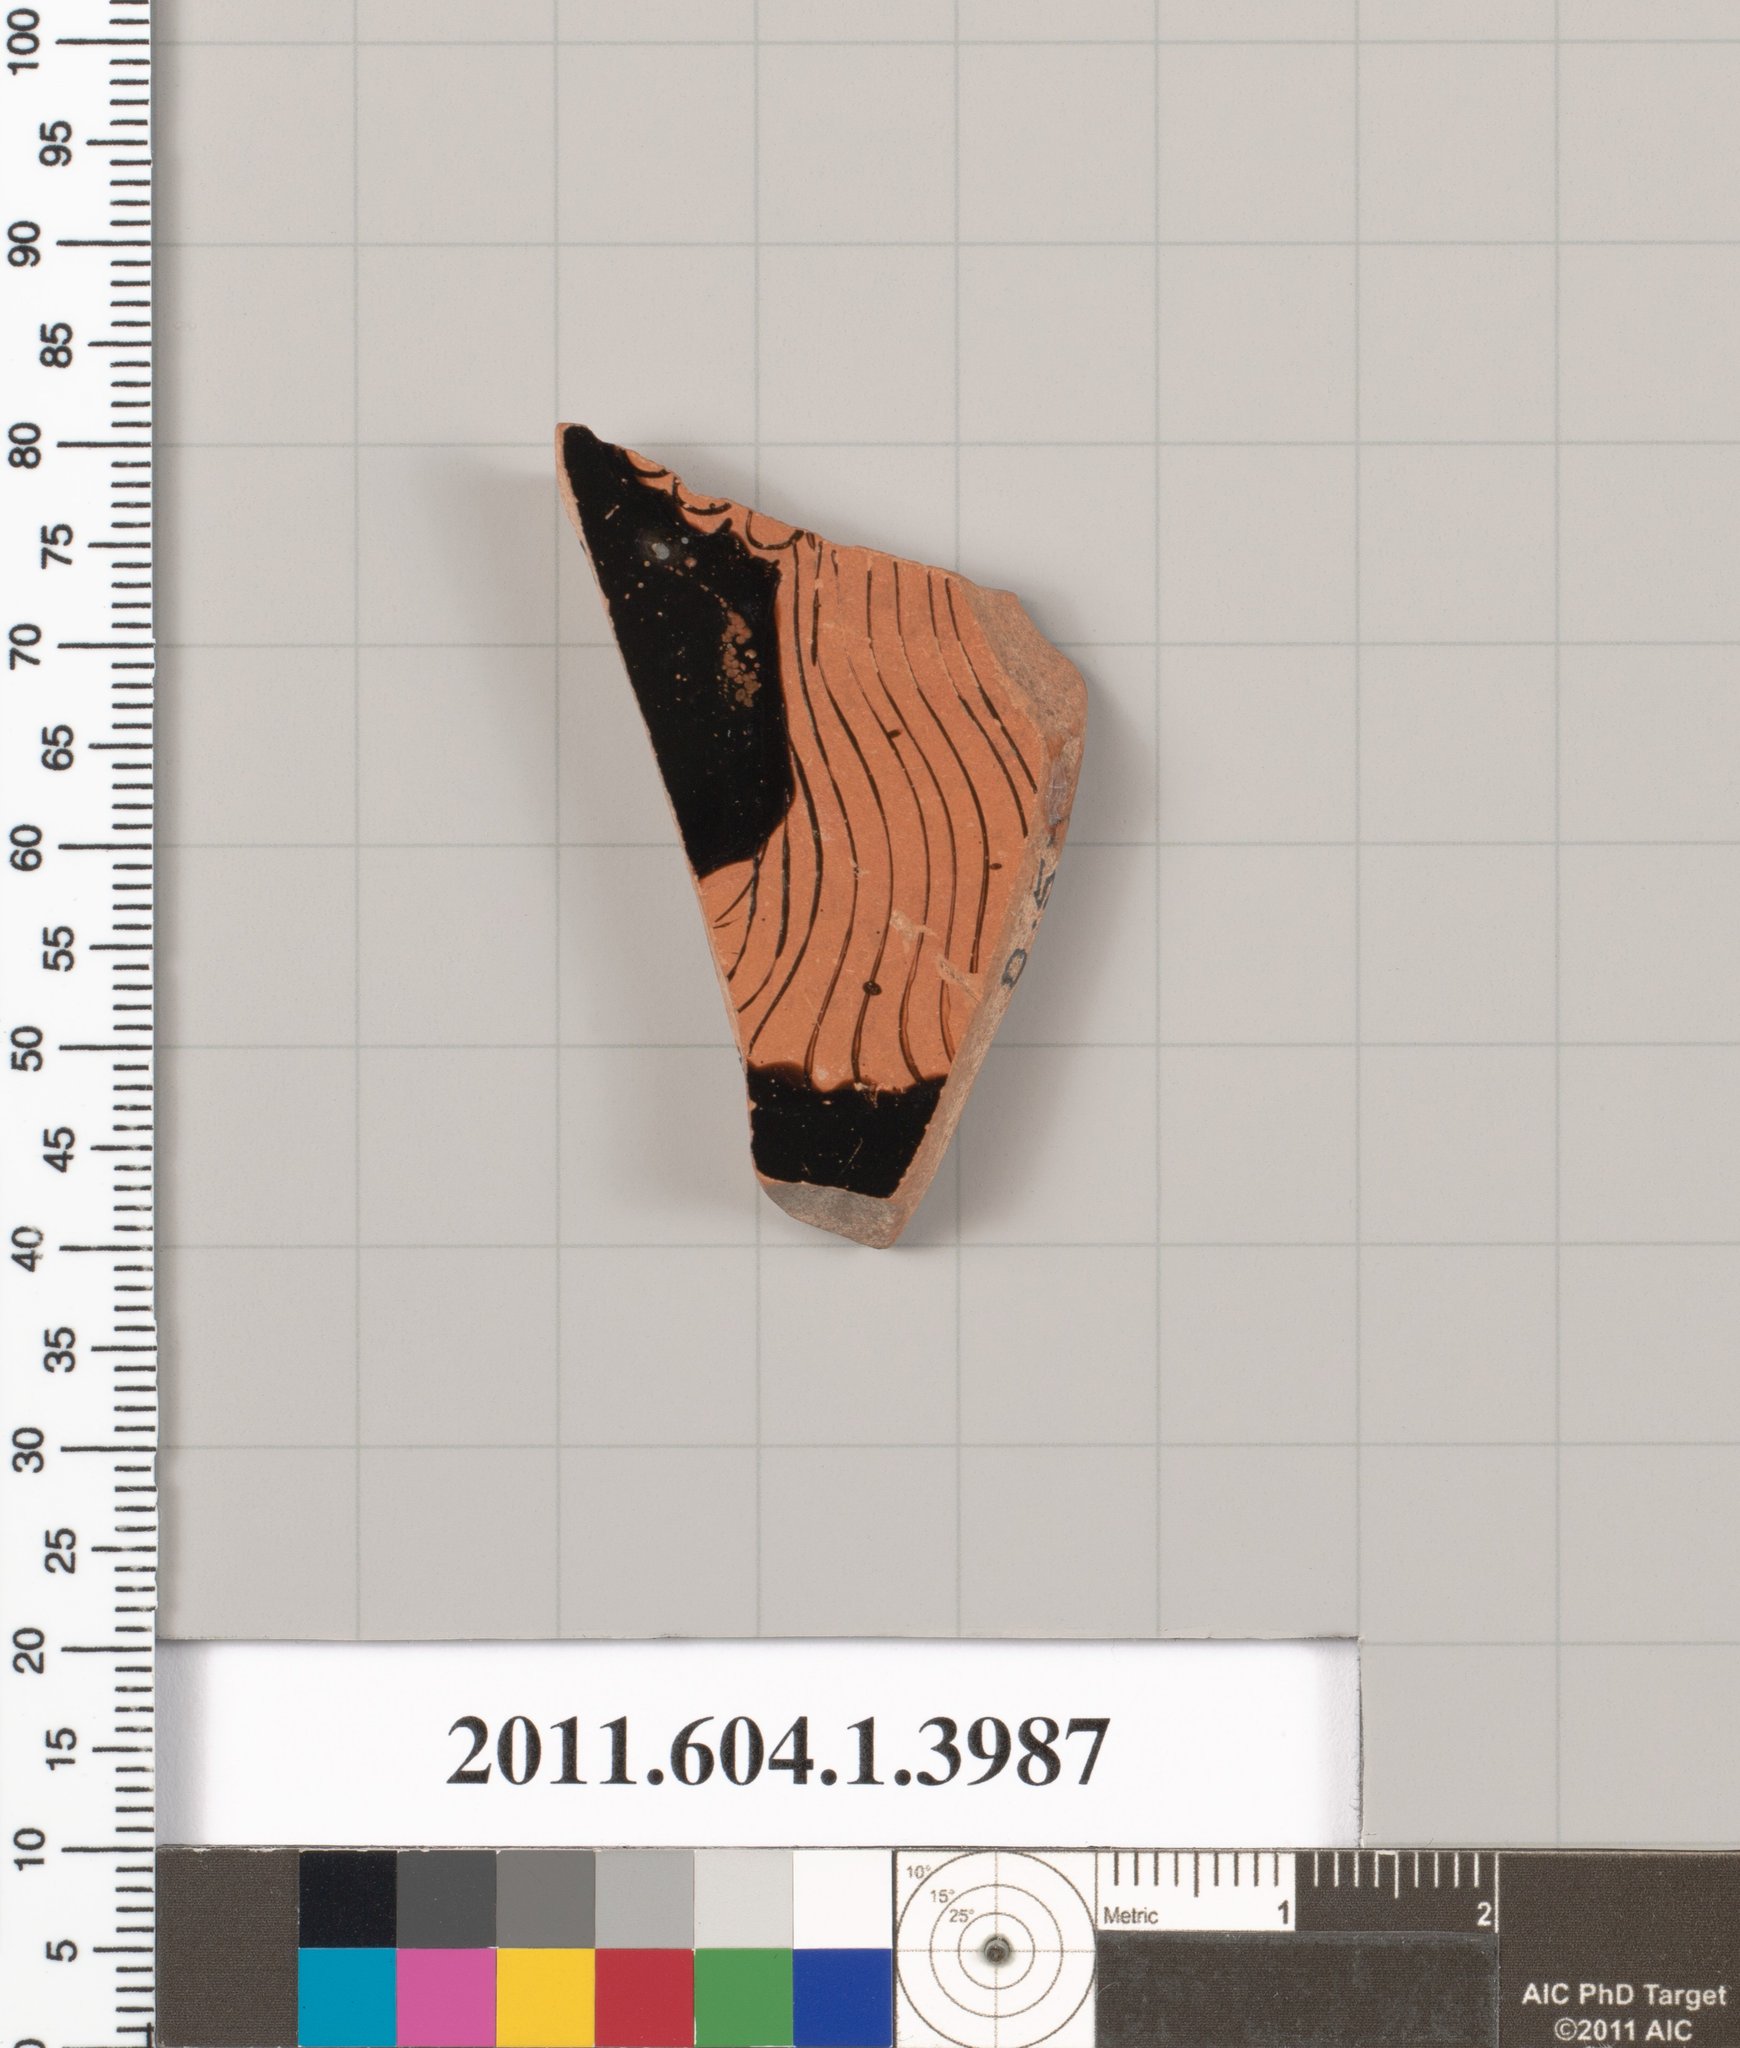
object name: kylix fragment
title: Terracotta fragment of a kylix (drinking cup)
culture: greek, attic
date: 475-451 BCE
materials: terracotta